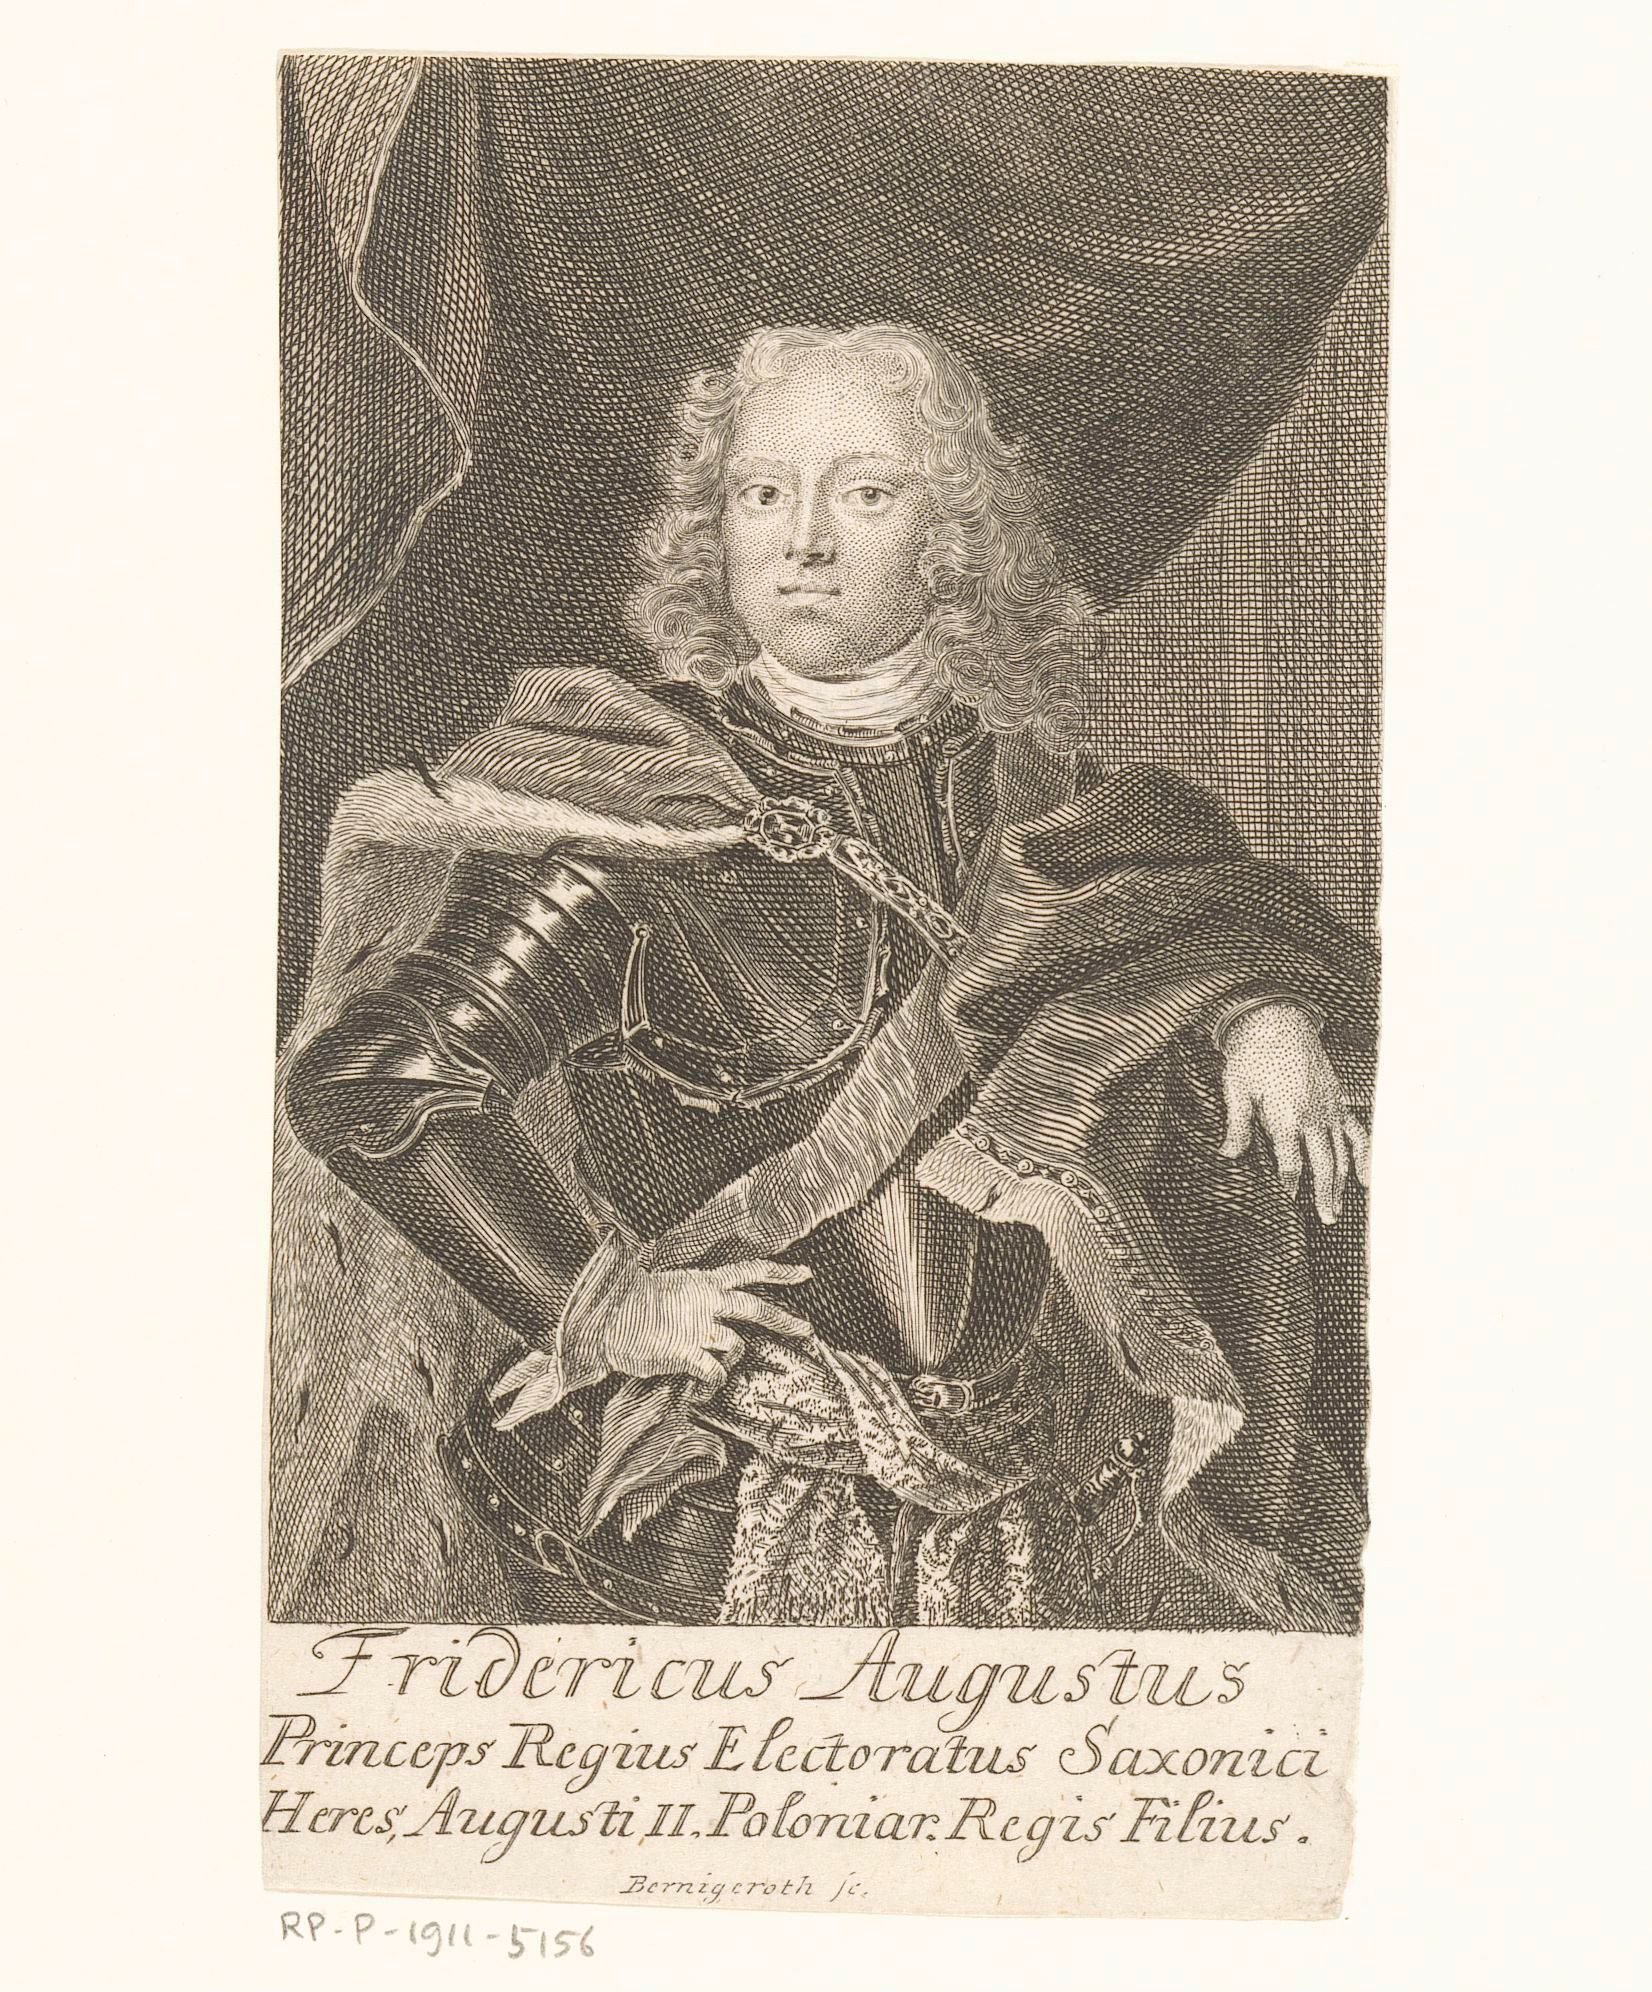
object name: print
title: Portret van Friedrich August II von Sachsen, later koning August III van Polen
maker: martin bernigeroth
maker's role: print maker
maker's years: 1670-1733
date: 1710-1733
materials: paper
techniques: engraving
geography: leipzig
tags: augustus iii (king of poland), armour, historical persons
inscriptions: collector's mark: Lugt 2228